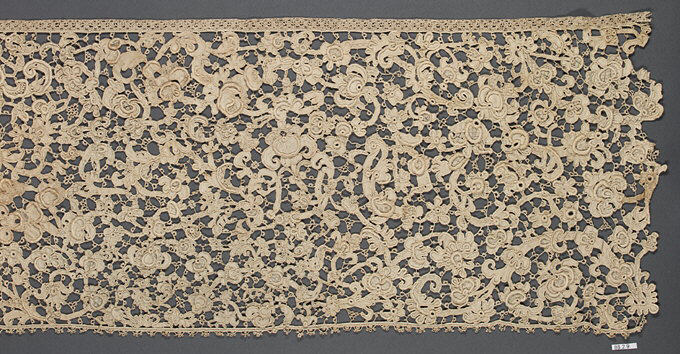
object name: fragment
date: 1601-1700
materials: lace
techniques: lace, gros point